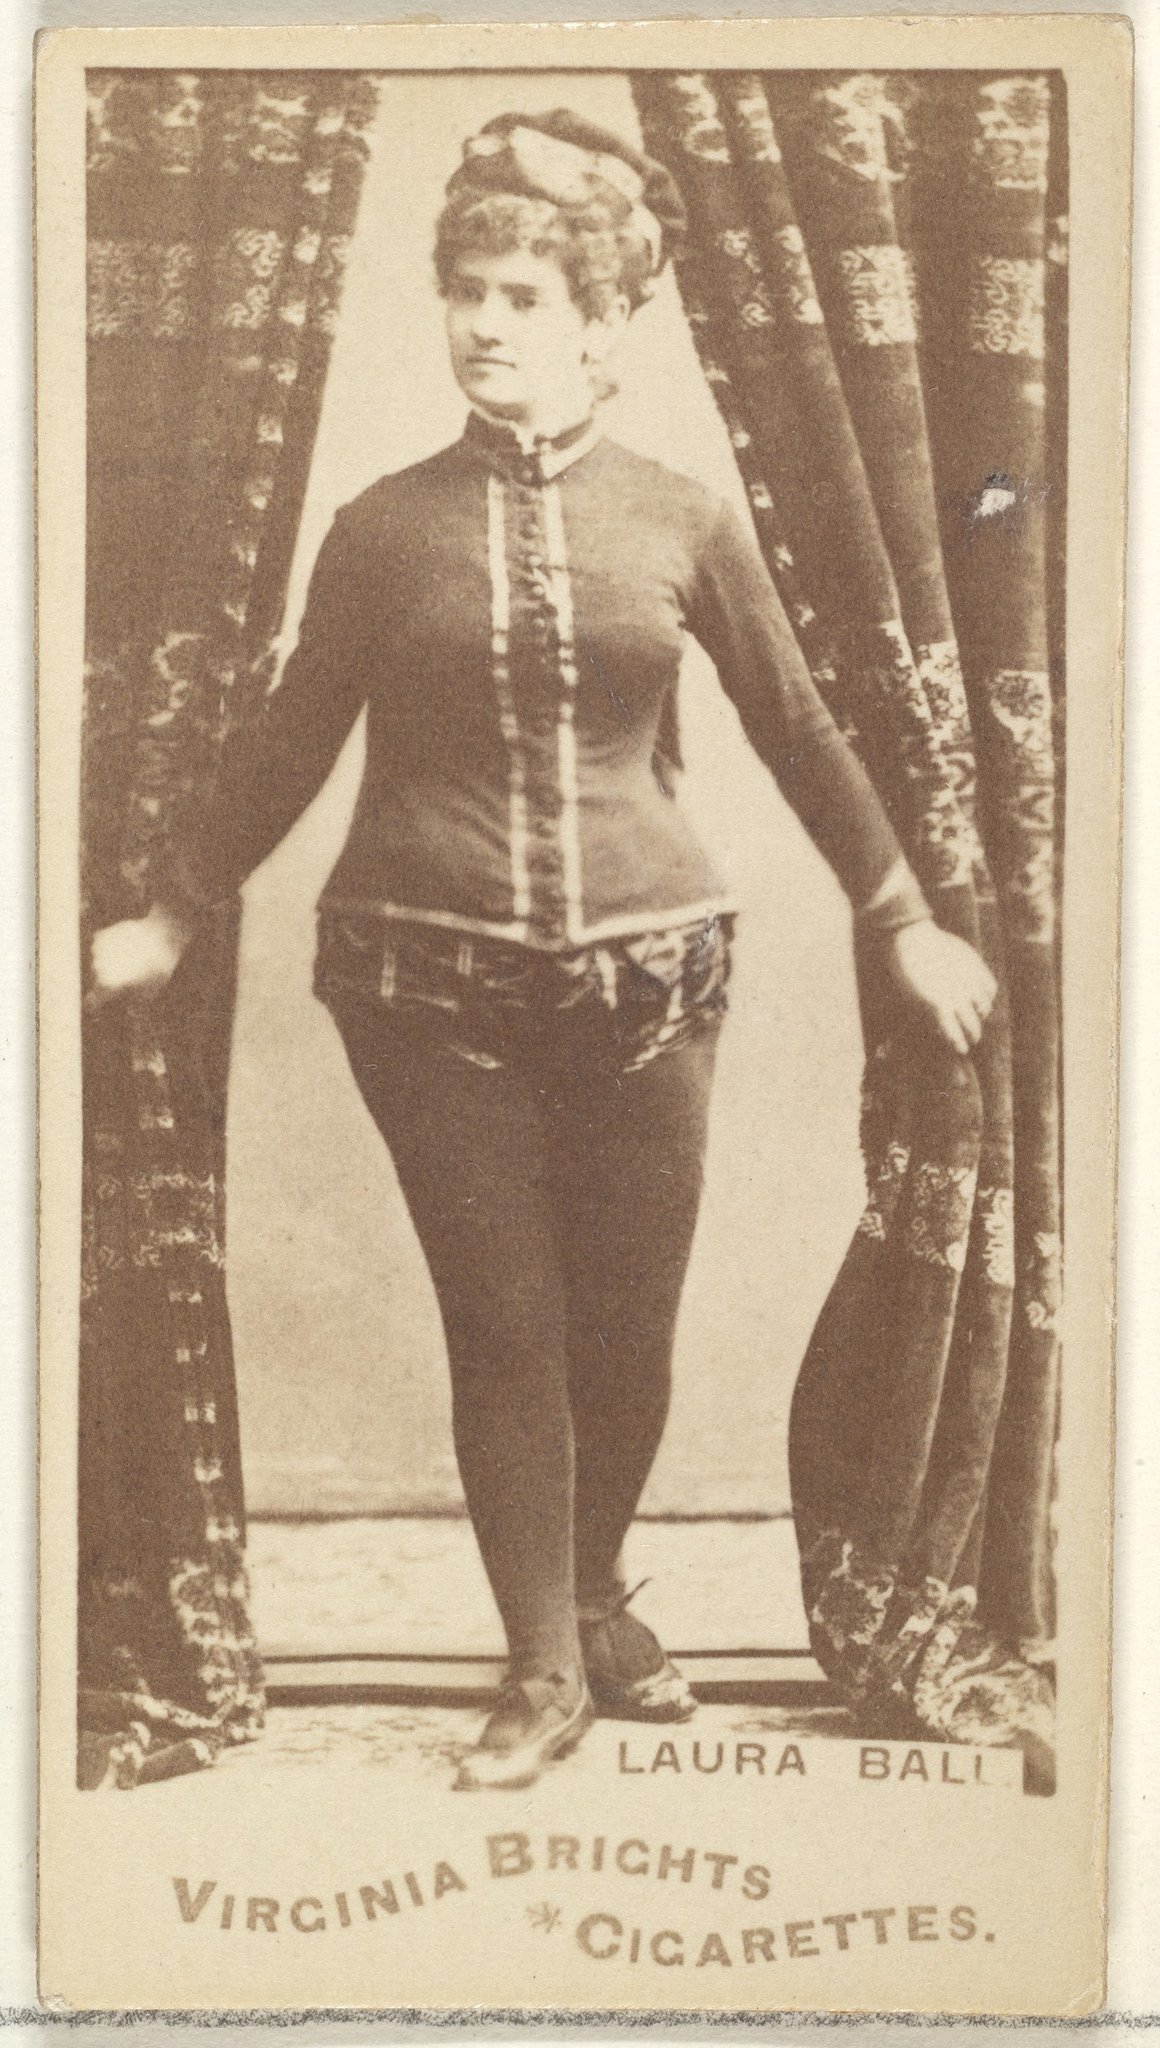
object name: photograph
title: Laura Ball, from the Actors and Actresses series (N45, Type 1) for Virginia Brights Cigarettes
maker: allen & ginter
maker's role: publisher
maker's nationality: american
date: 1888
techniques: albumen silver print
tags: portraits,women,actresses